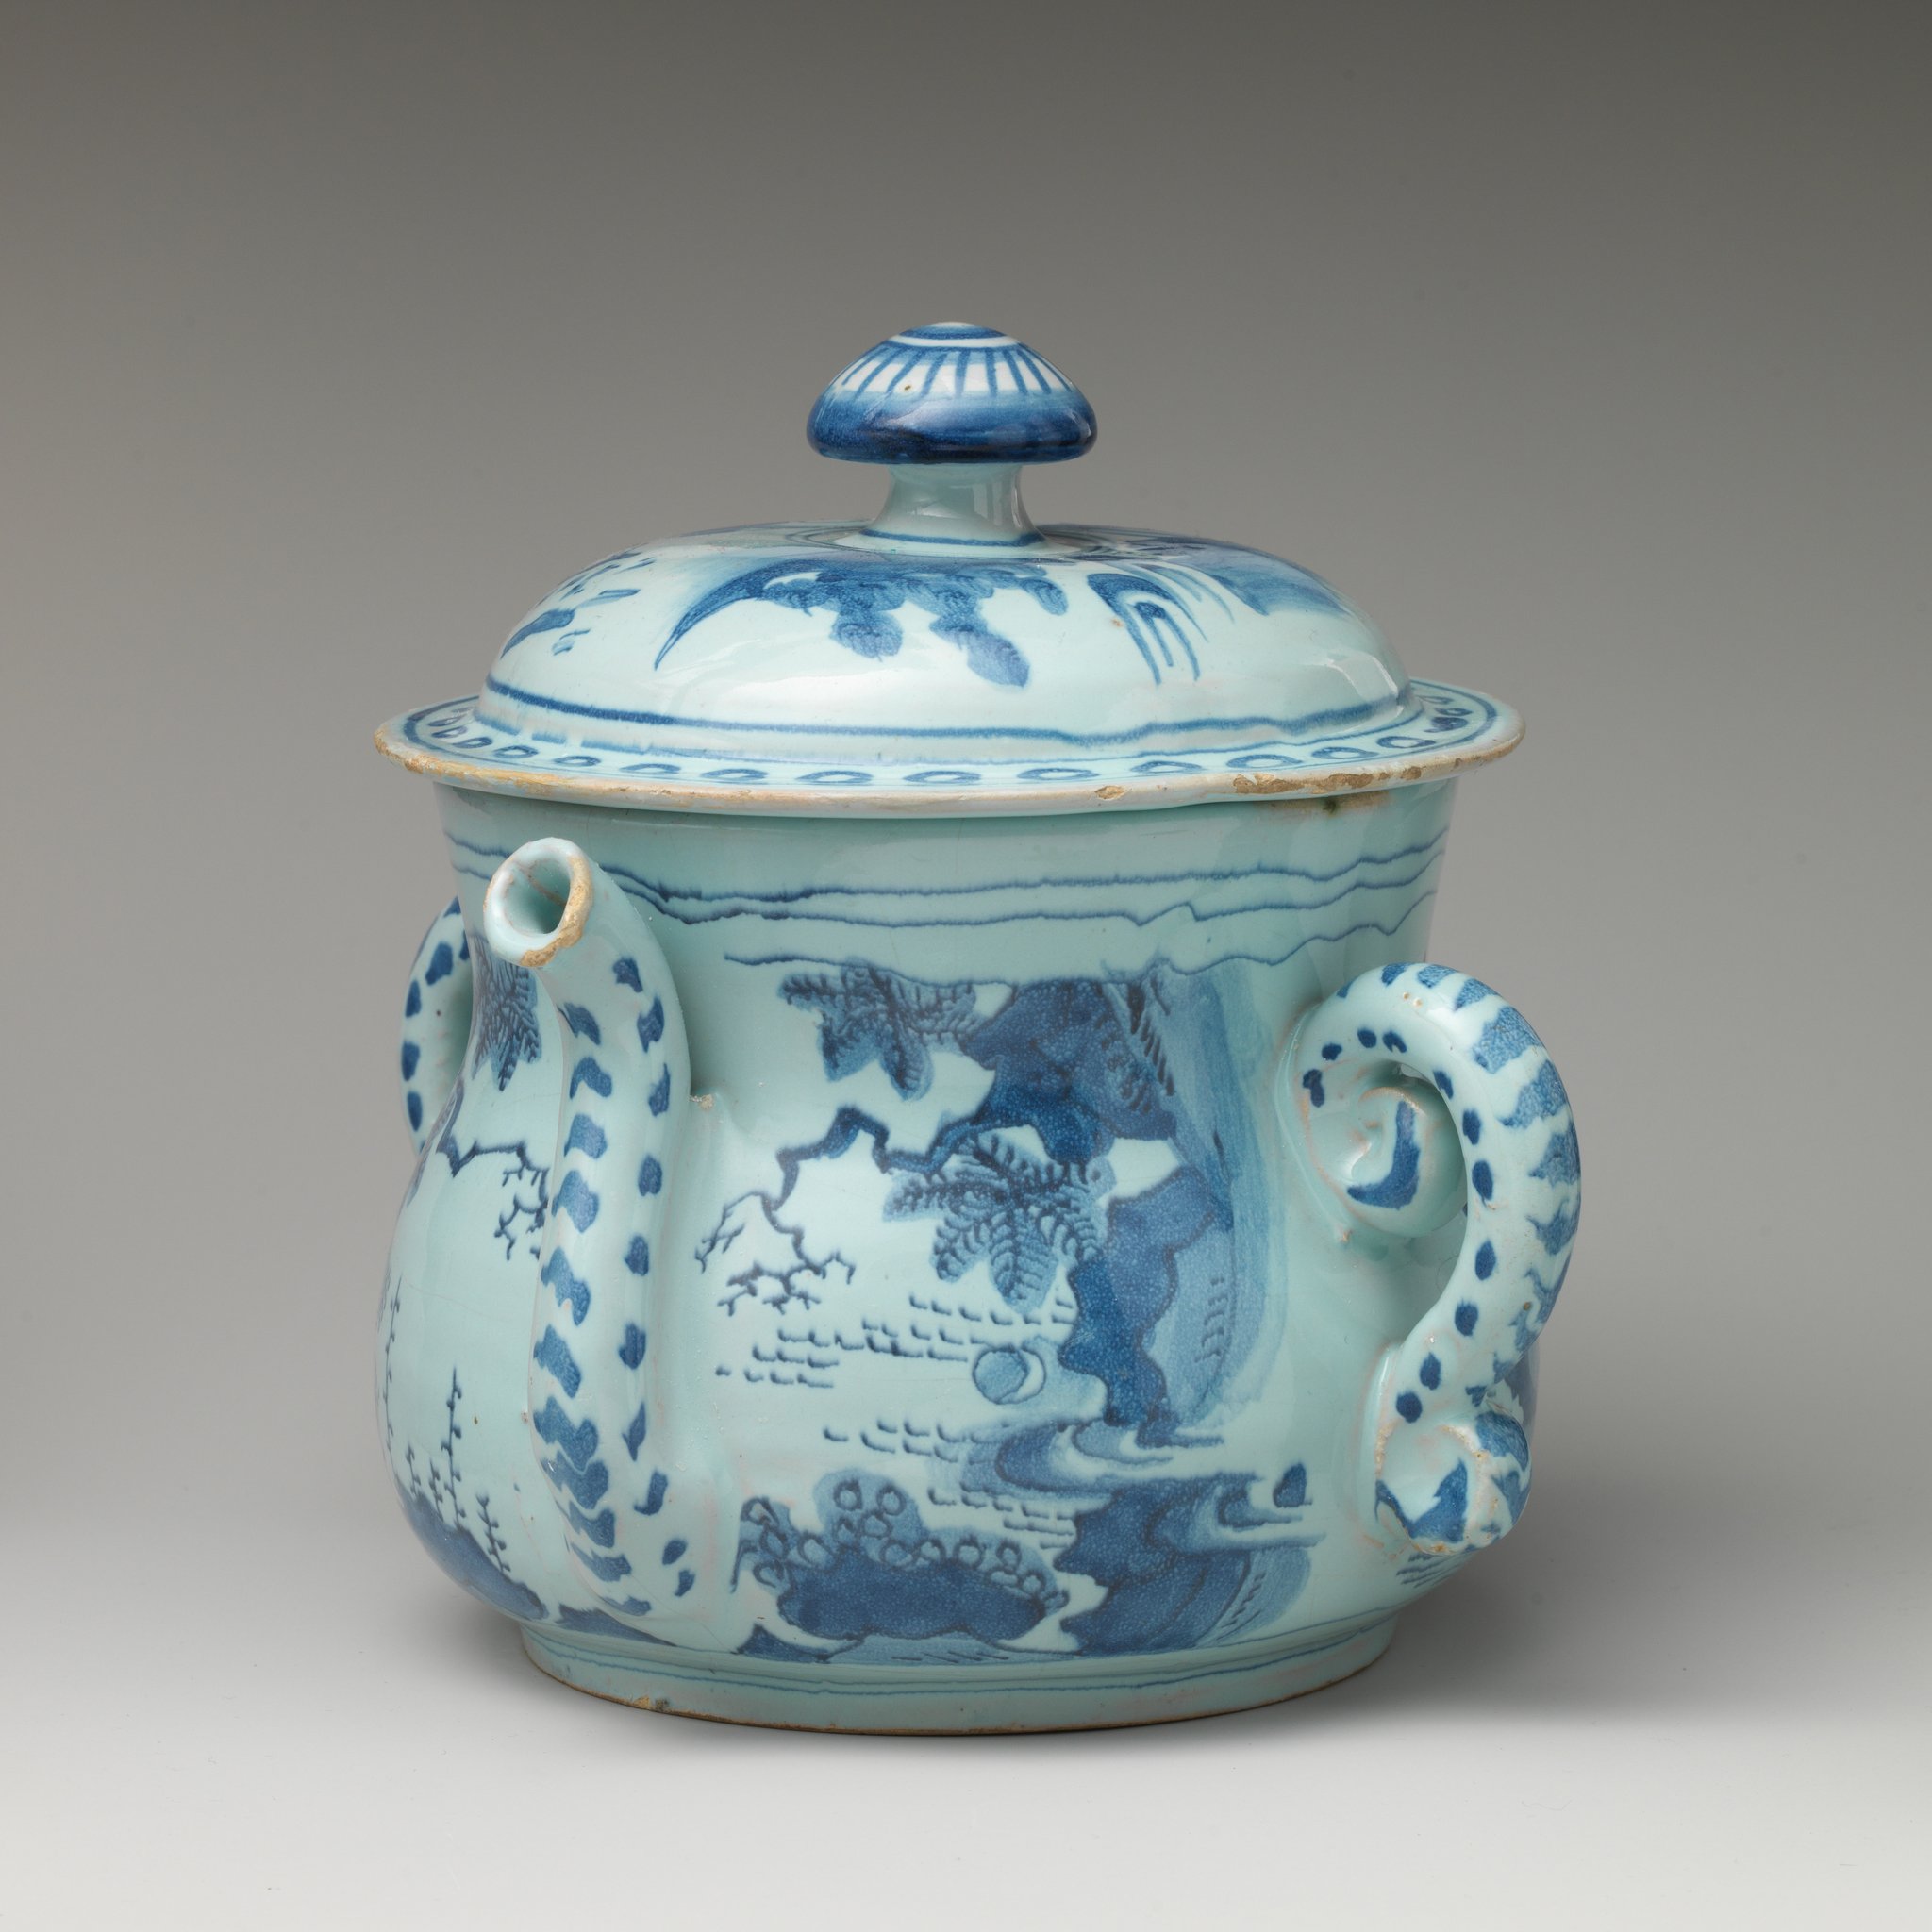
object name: pot with cover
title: Posset pot with cover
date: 1701-1733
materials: earthenware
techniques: glazing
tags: human figures